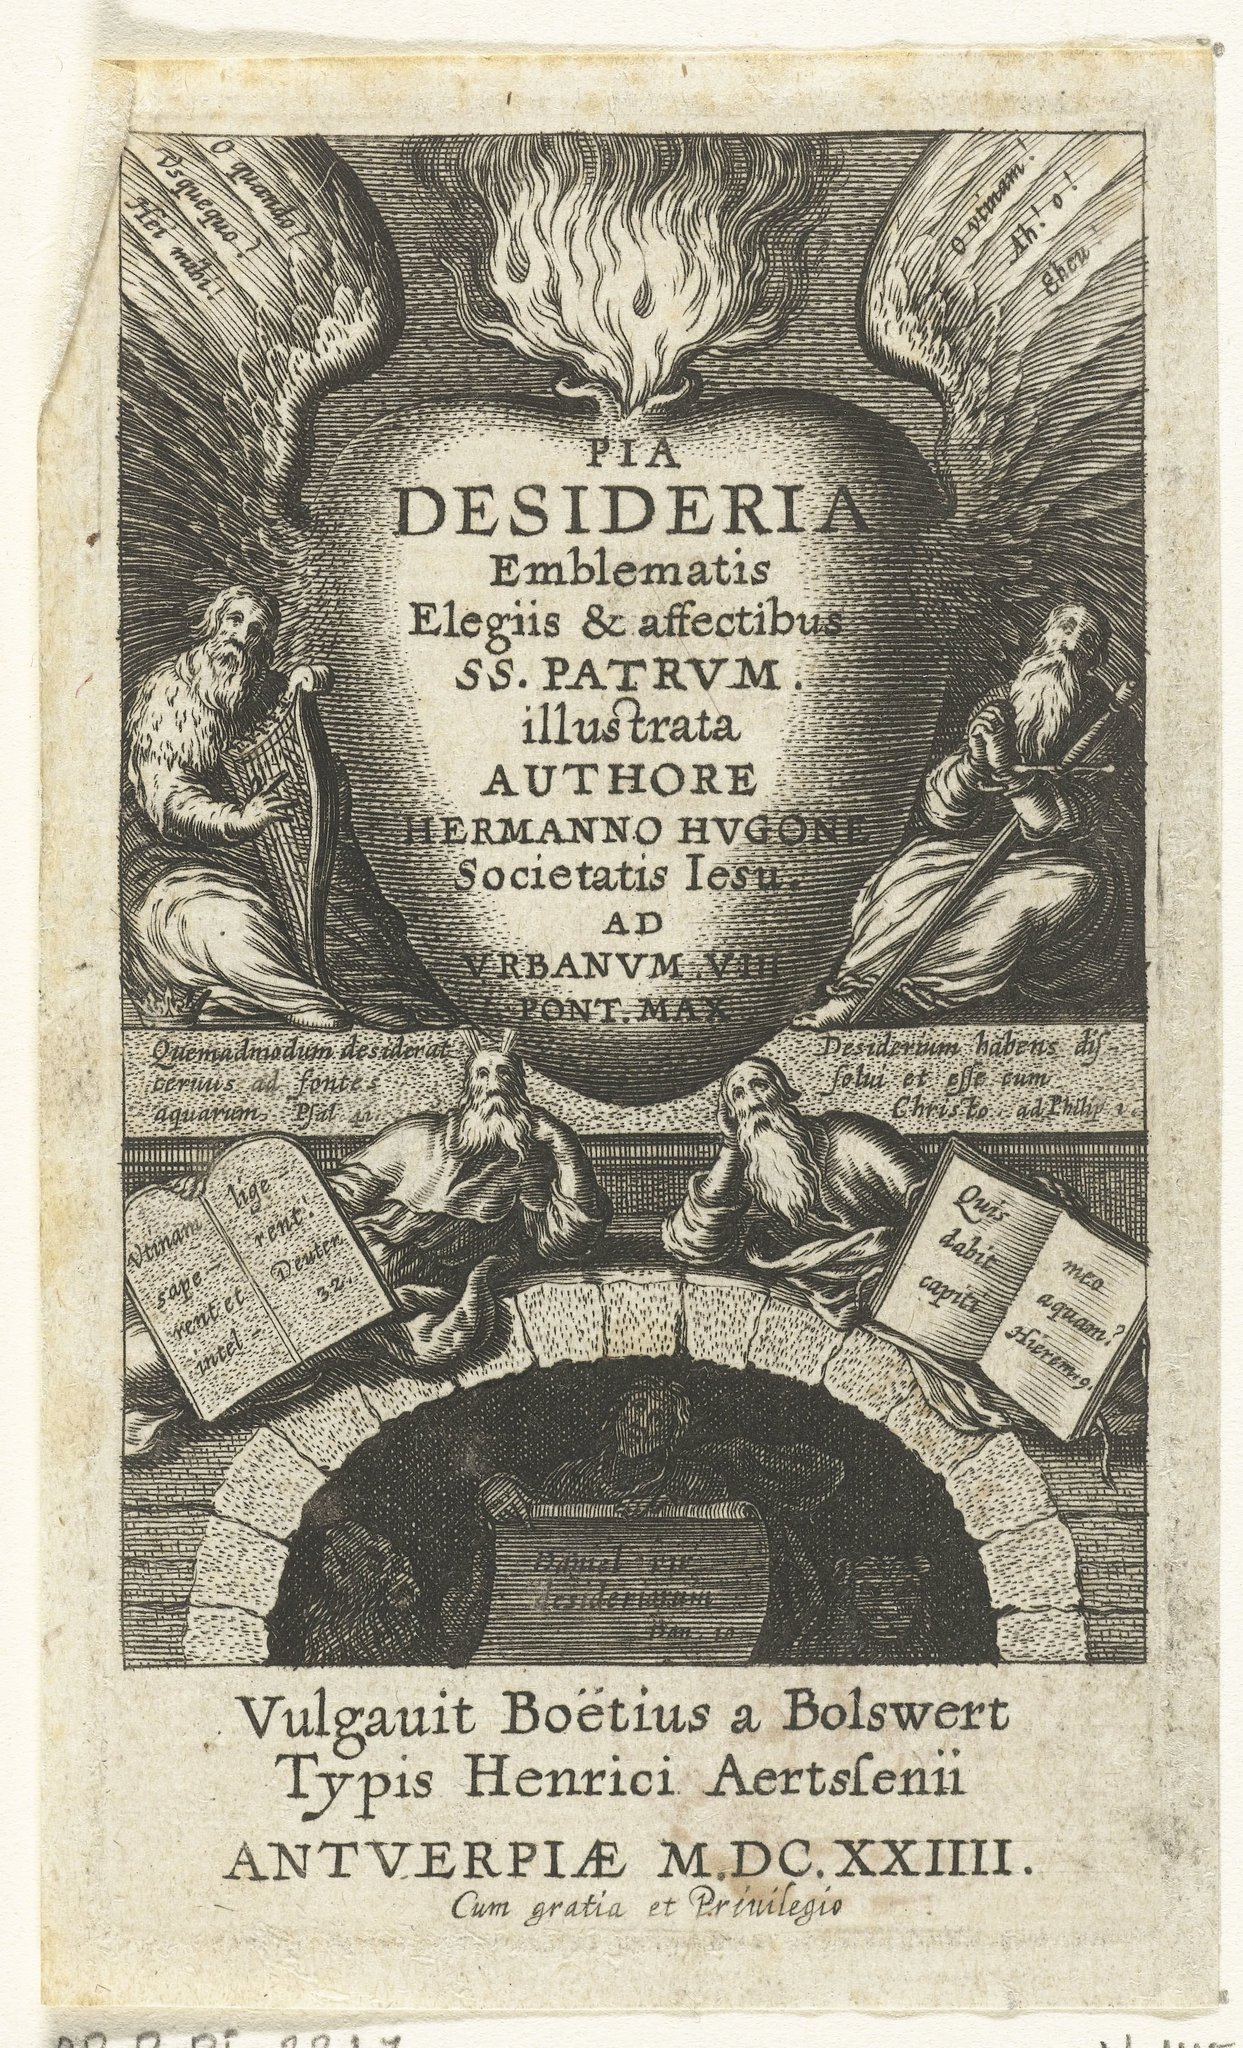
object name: titelblad, titelpagina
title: Pia desideria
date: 1624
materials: paper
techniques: engraving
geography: antwerp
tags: david (not in biblical context); possible attributes: crown, harp, the apostle philip; possible attributes: book, cross, dish with snake, lance, scroll, stone, sword, the monk and hermit jerome (hieronymus); possible attributes: book, cardinal's hat, crucifix, hour-glass, lion, skull, stone, moses (not in biblical context); possible attributes: rays of light or horns on his head, rod, tables of the law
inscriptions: collector's mark: Lugt 240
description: Titelpagina voor: Herman Hugo, Pia desideria emblematis, elegiis & affectibus S. S. Patrum illustrata, Antwerpen 1624